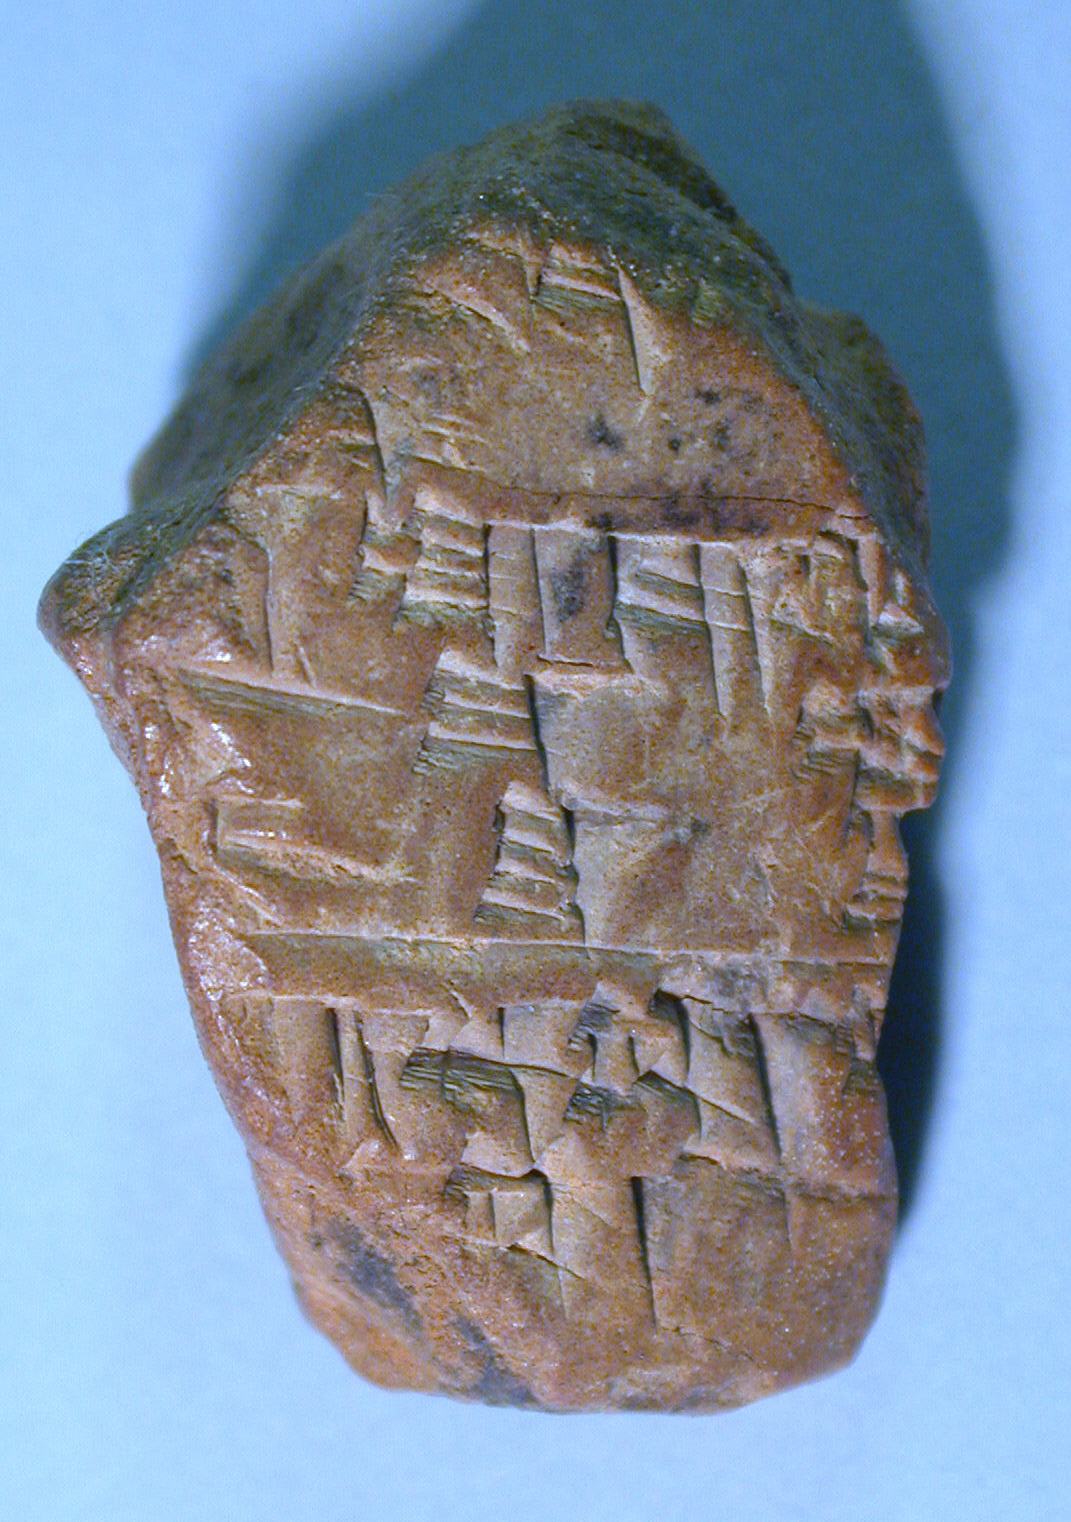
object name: cuneiform tablet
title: Cuneiform tablet: fragment of an Emesal prayer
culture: parthian or seleucid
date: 200-1 BCE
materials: clay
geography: mesopotamia